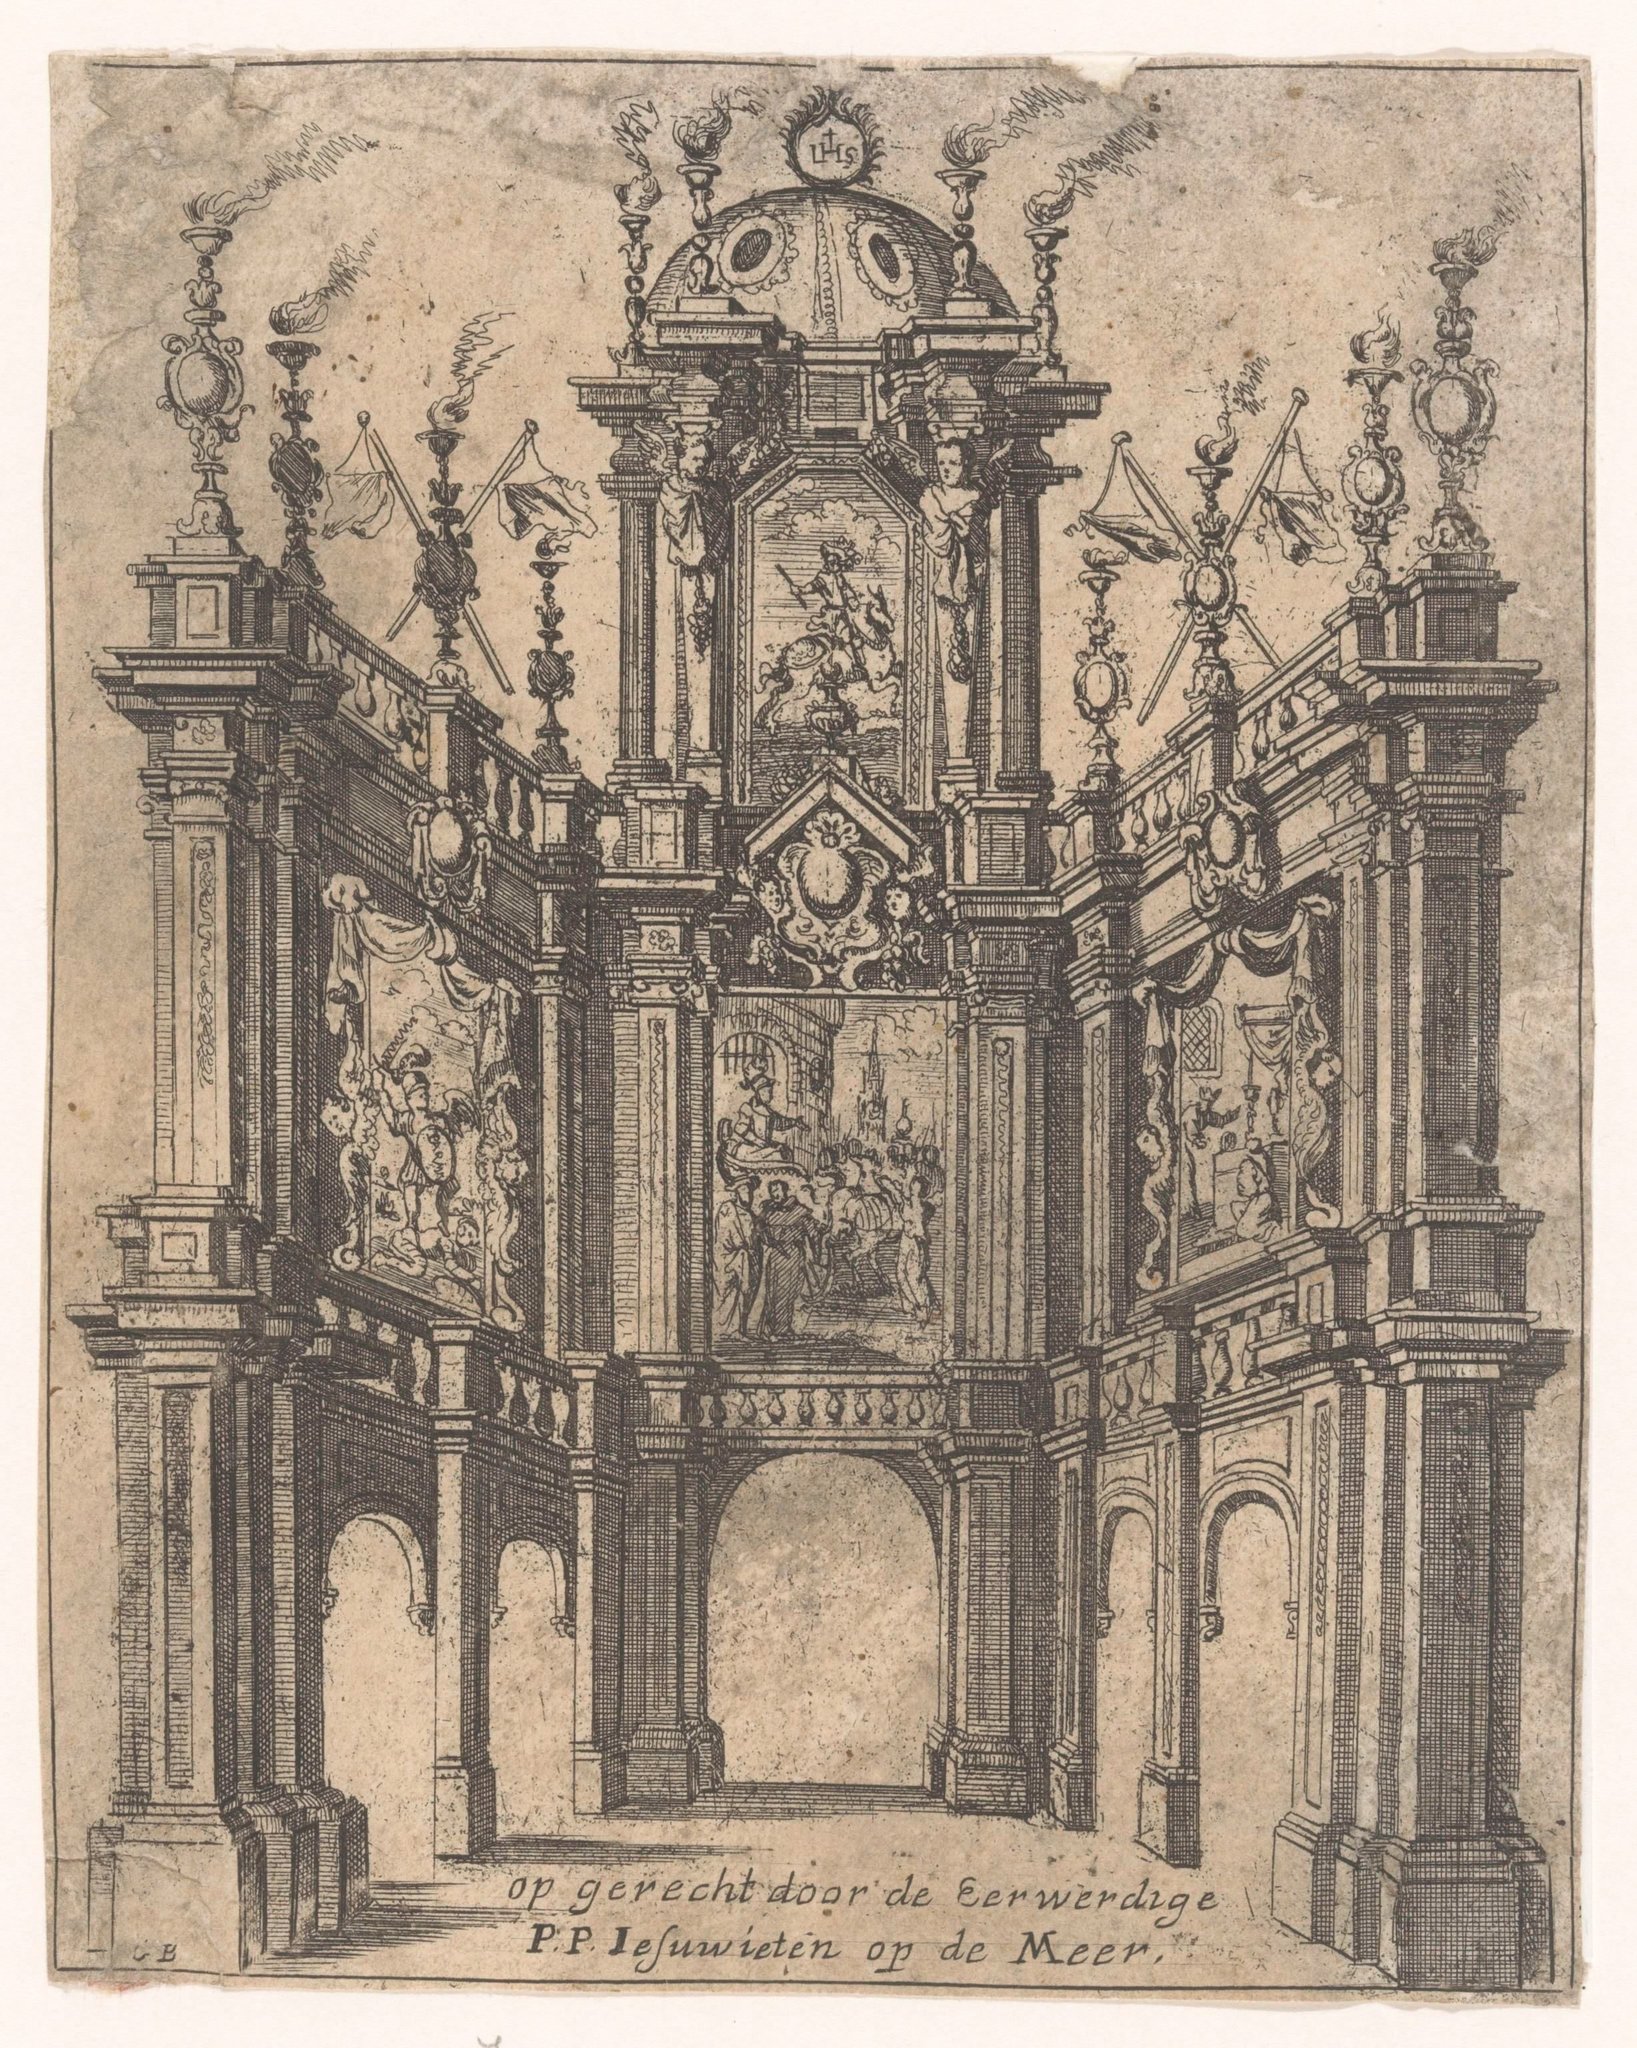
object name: ornament print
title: Triomfpoort opgericht op de Kaasrui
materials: paper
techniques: etching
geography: antwerp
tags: triumphal arch, antwerp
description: Prent uit: Hondert-jaerigh jubile-vreught bewesen in dese stadt Antwerpen ter oorsaecke vande herstellinge des geloofs in't jaer 1585. door de glorieuse waepenen van sijne catholijcke majesteyt, onder t'beleyt van (...) Alexander Farnesius (...) Antwerpen: Verdussen den jonghere, Hieronymus, 1685.